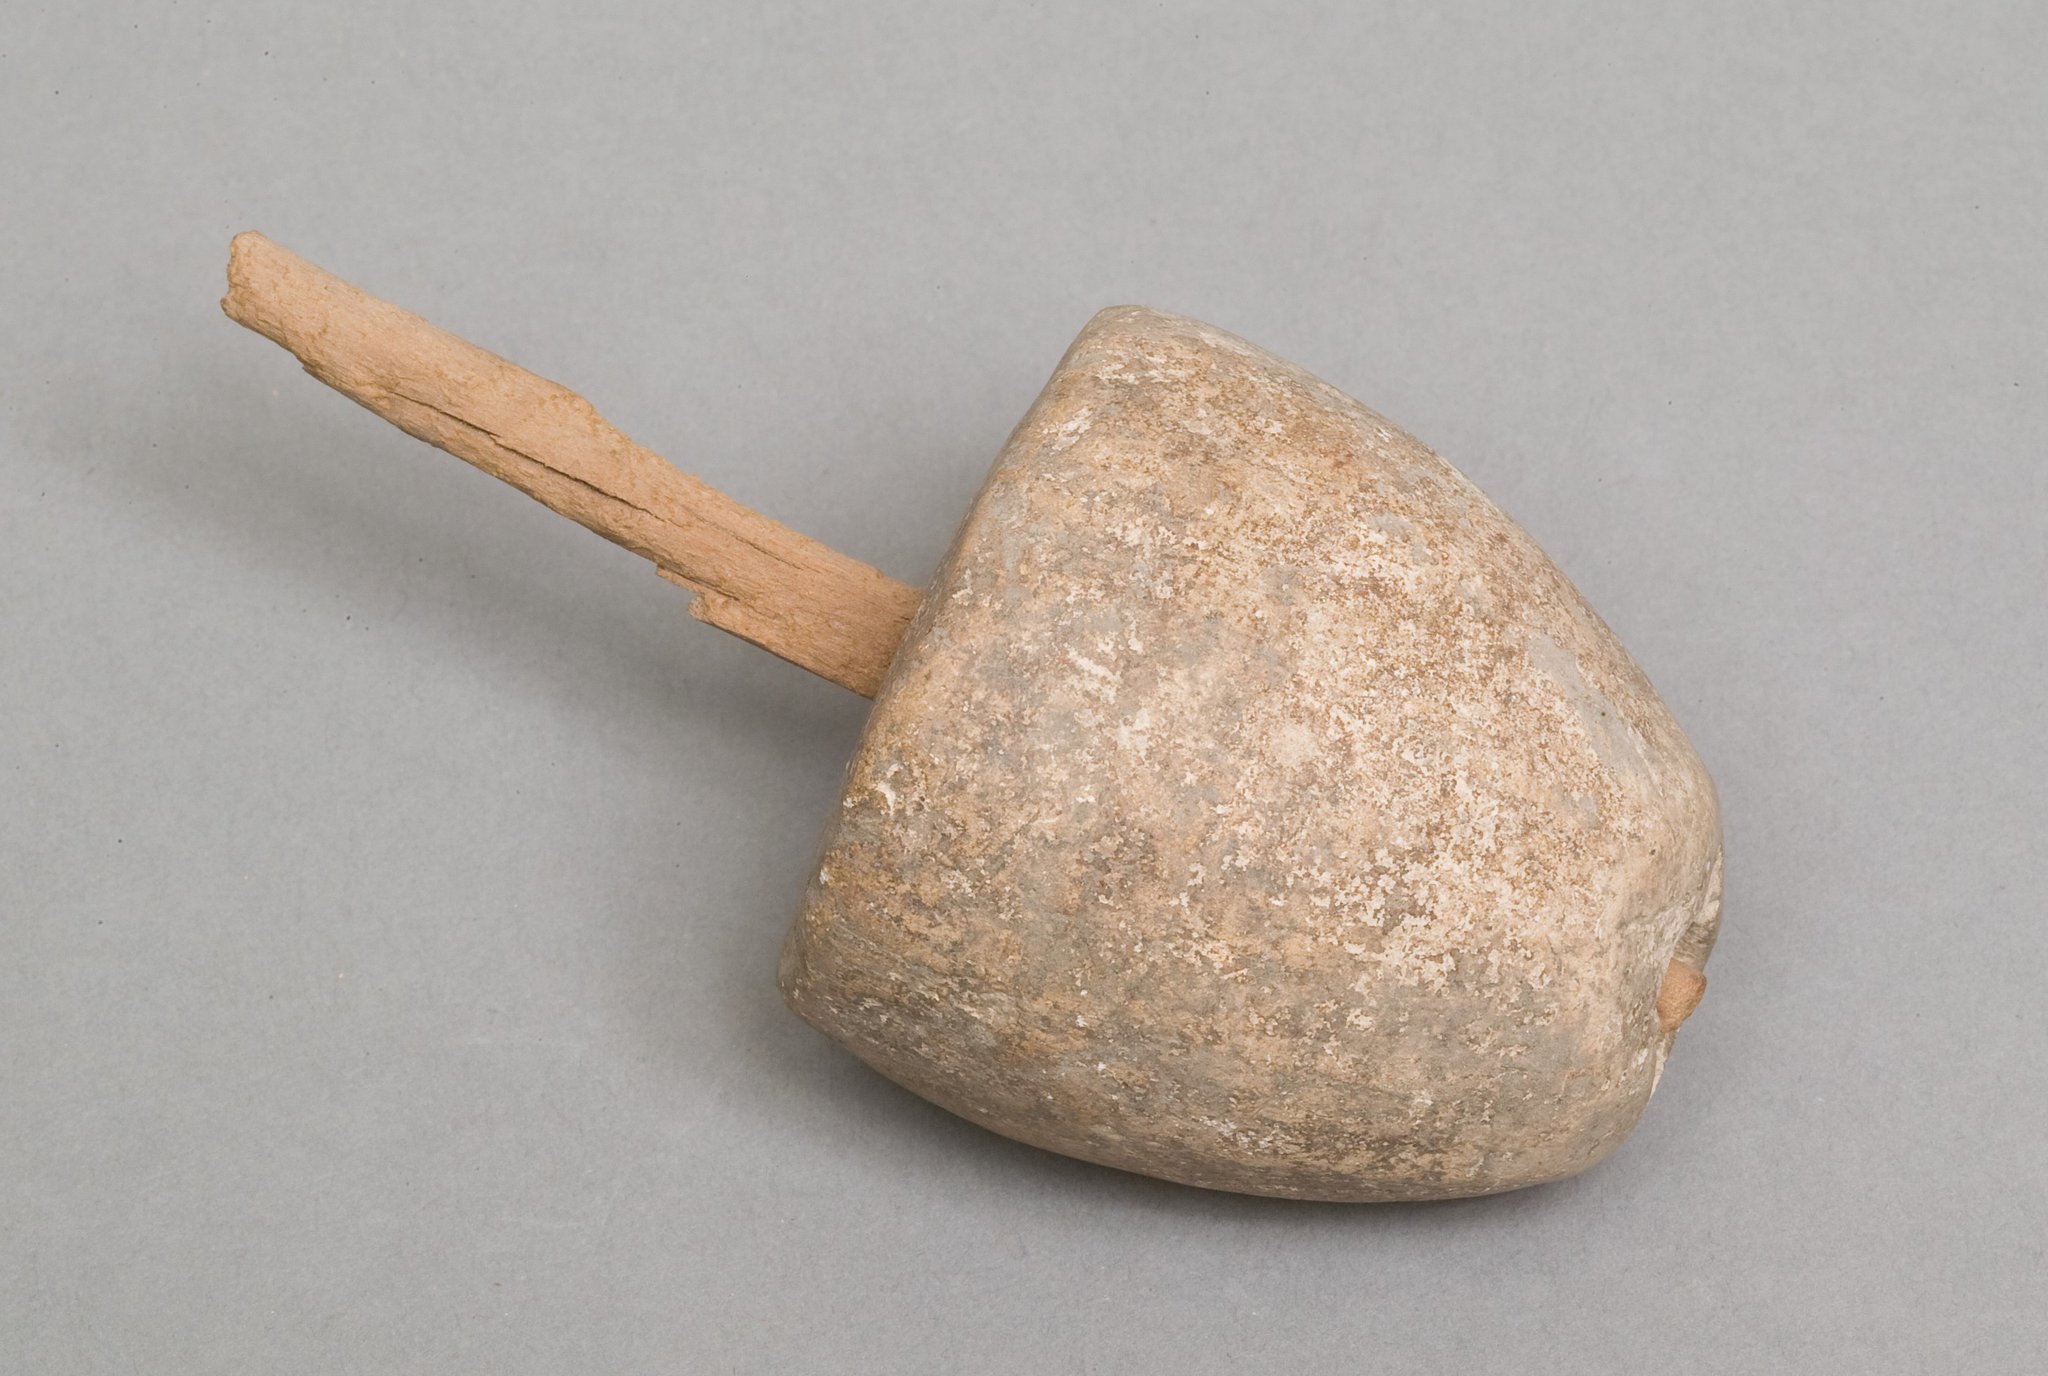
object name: spindle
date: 1295-1070 BCE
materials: limestone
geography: egypt